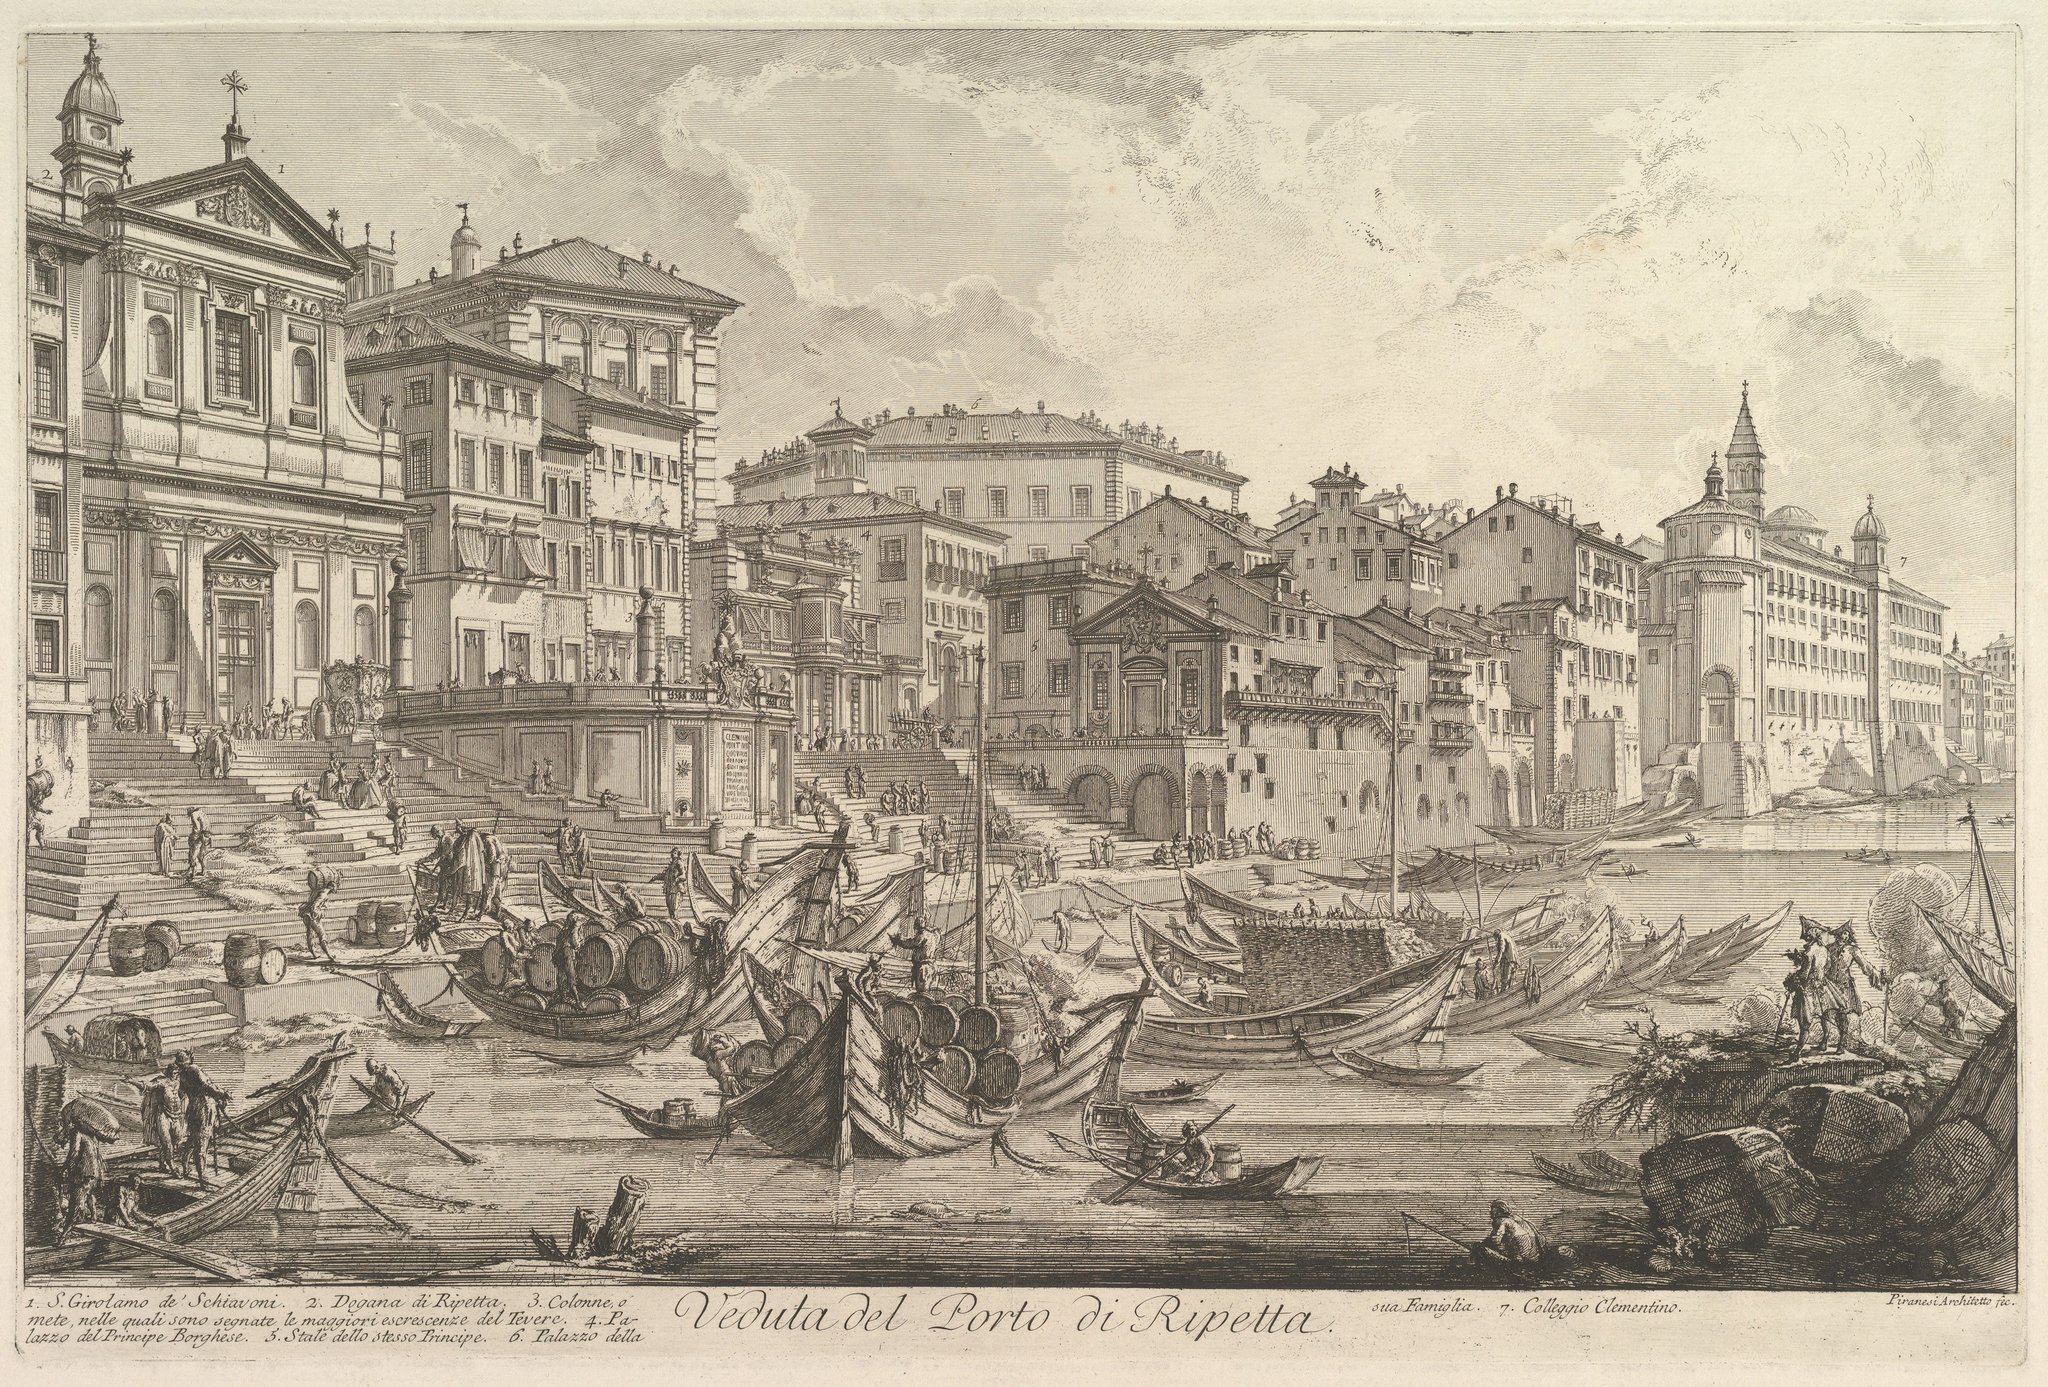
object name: print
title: The smaller harbor, called the Porto di Ripetta (Veduta del Porto di Ripetta)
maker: giovanni battista piranesi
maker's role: artist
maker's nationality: italian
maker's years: 1720-1778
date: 1753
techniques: etching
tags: buildings,boats,harbors,barrels